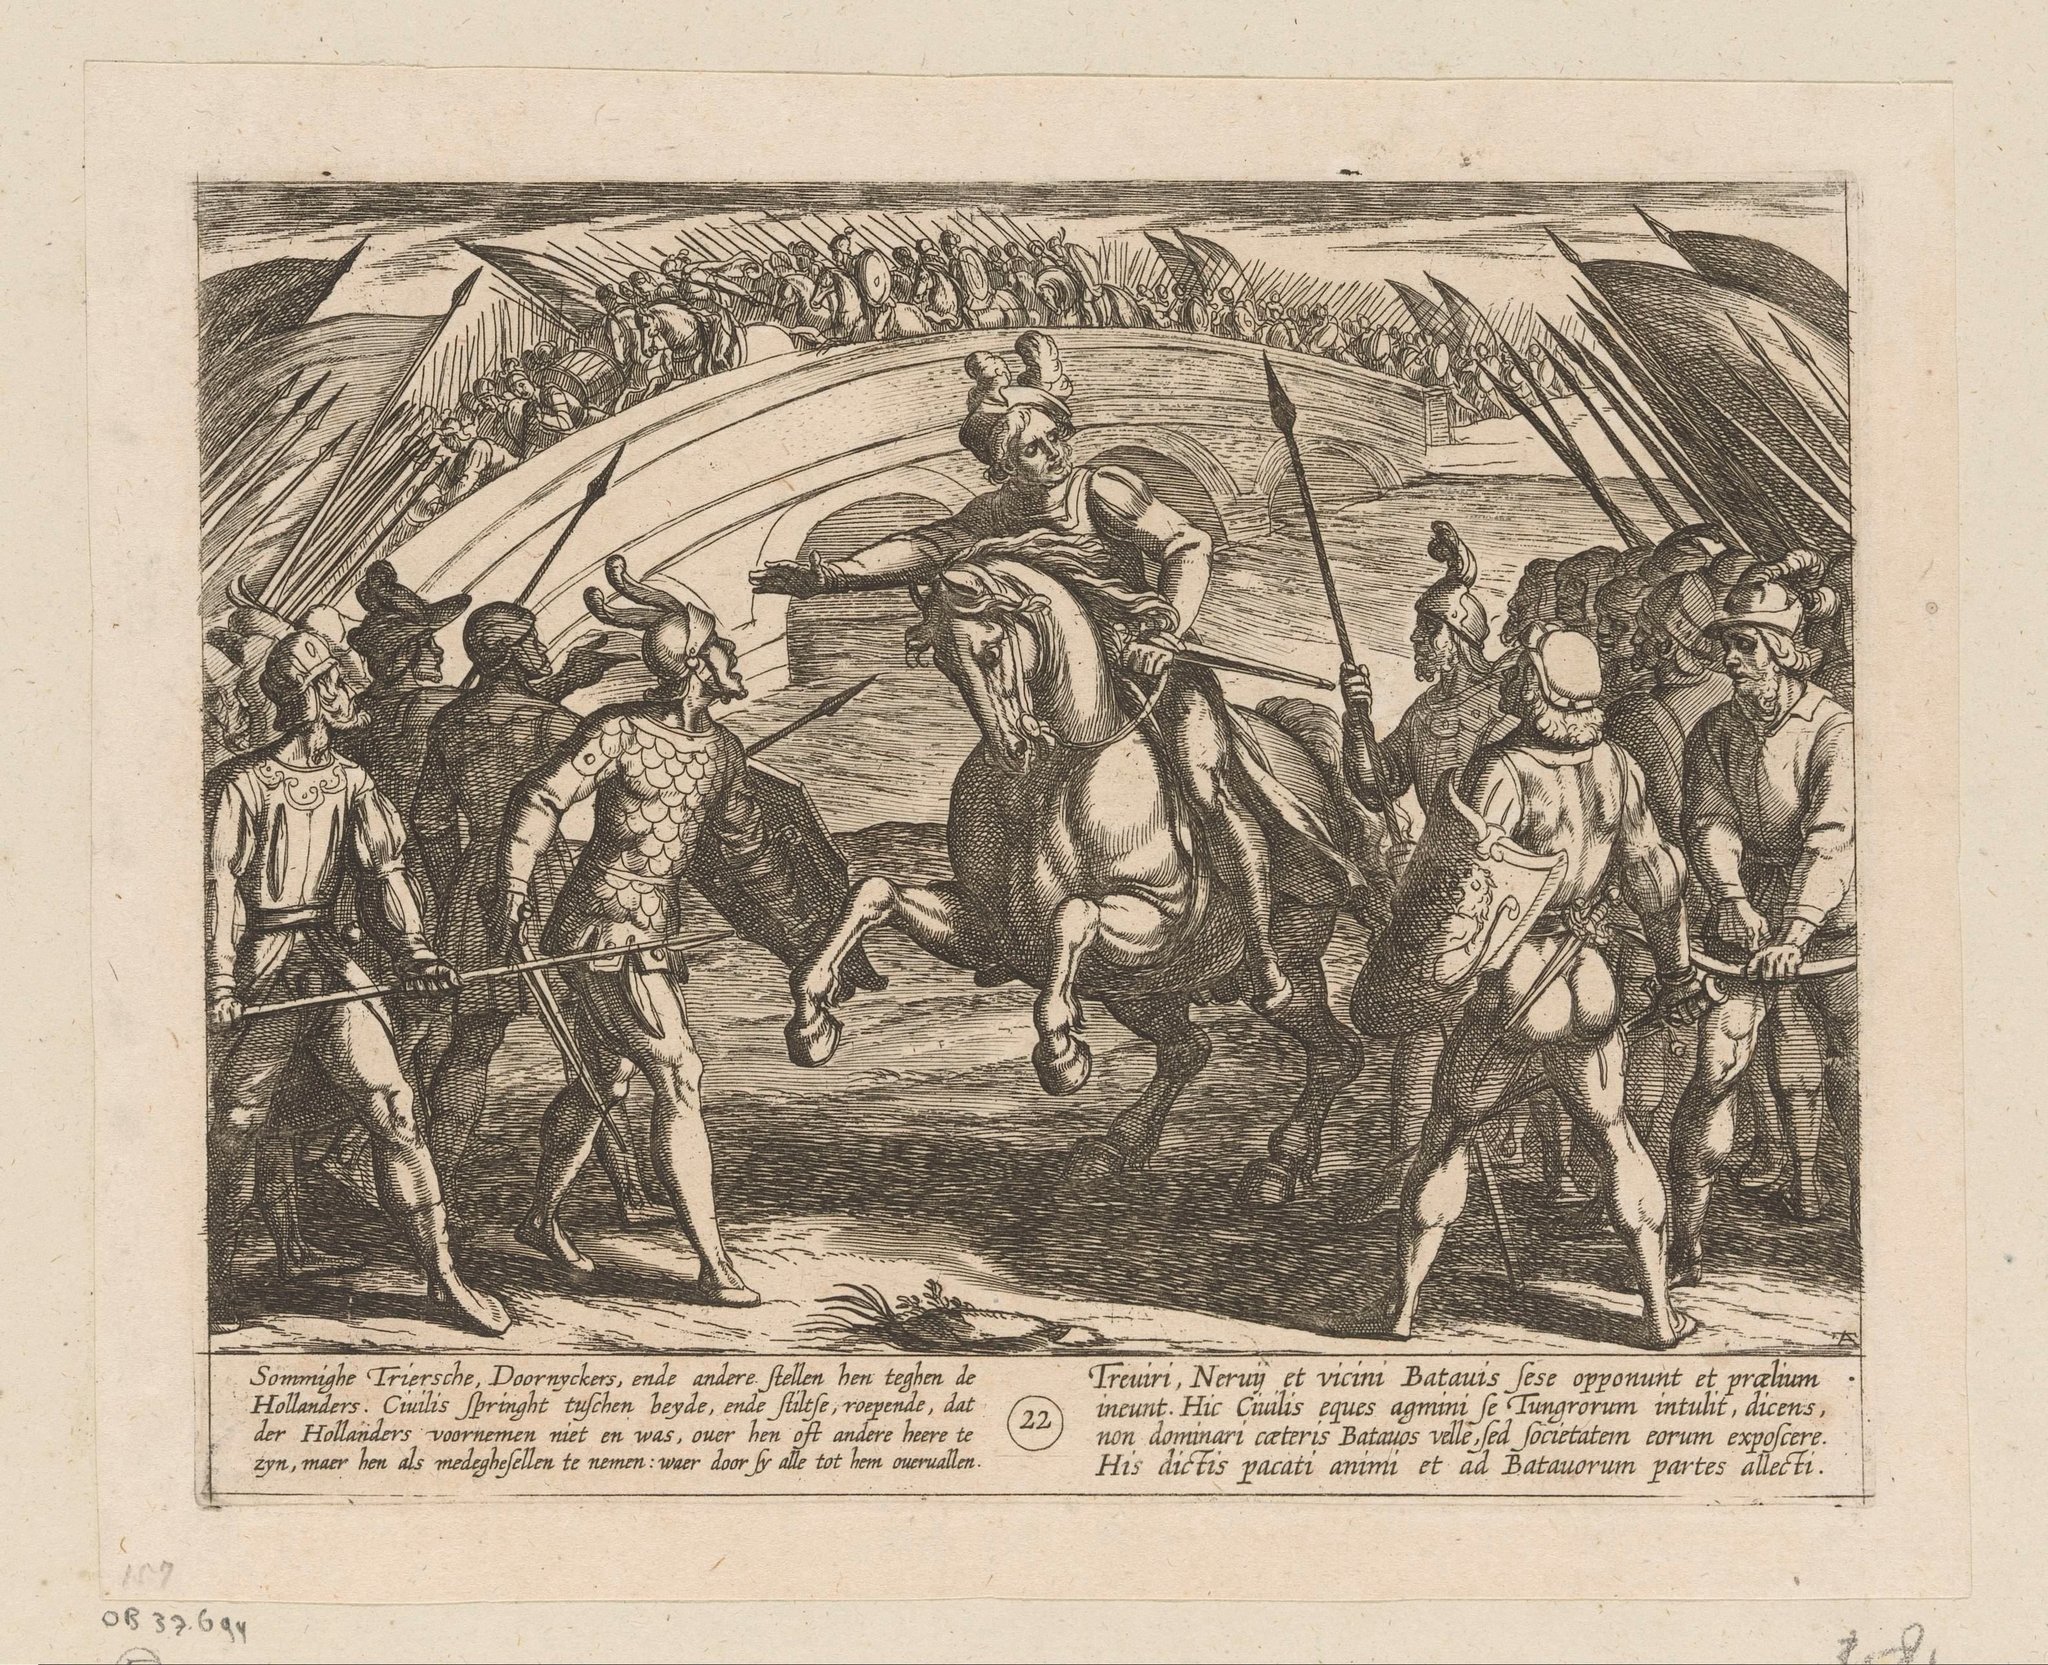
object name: print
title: Civilis voorkomt ruzie tussen de Nederlandse en de Duitse soldaten, 69-70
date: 1612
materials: paper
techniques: etching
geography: italy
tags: battle, fighting in general, extinct, 'historical' peoples (with name), netherlands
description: Civilis komt tussenbeide en voorkomt dat de Nederlandse en de Duitse soldaten met elkaar slaags raken. Prent nummer 22 in de serie prenten over de Bataafse Opstand: Batavorum cum Romanis bellum / à Corn. Tacito lib. IV & V. : Hist. olim descriptum, figuris nunc aeneis expressum, auctore Othone Vaenio Lugdunobatava = De Batavische oft oude Hollandtsche oorloghe teghen de Romeynen. Otto Vaenius, Antwerpen 1612. Onderaan twee verzen van vier regels in het Nederlands en in het Latijn. Zonder tekst op achterzijde.